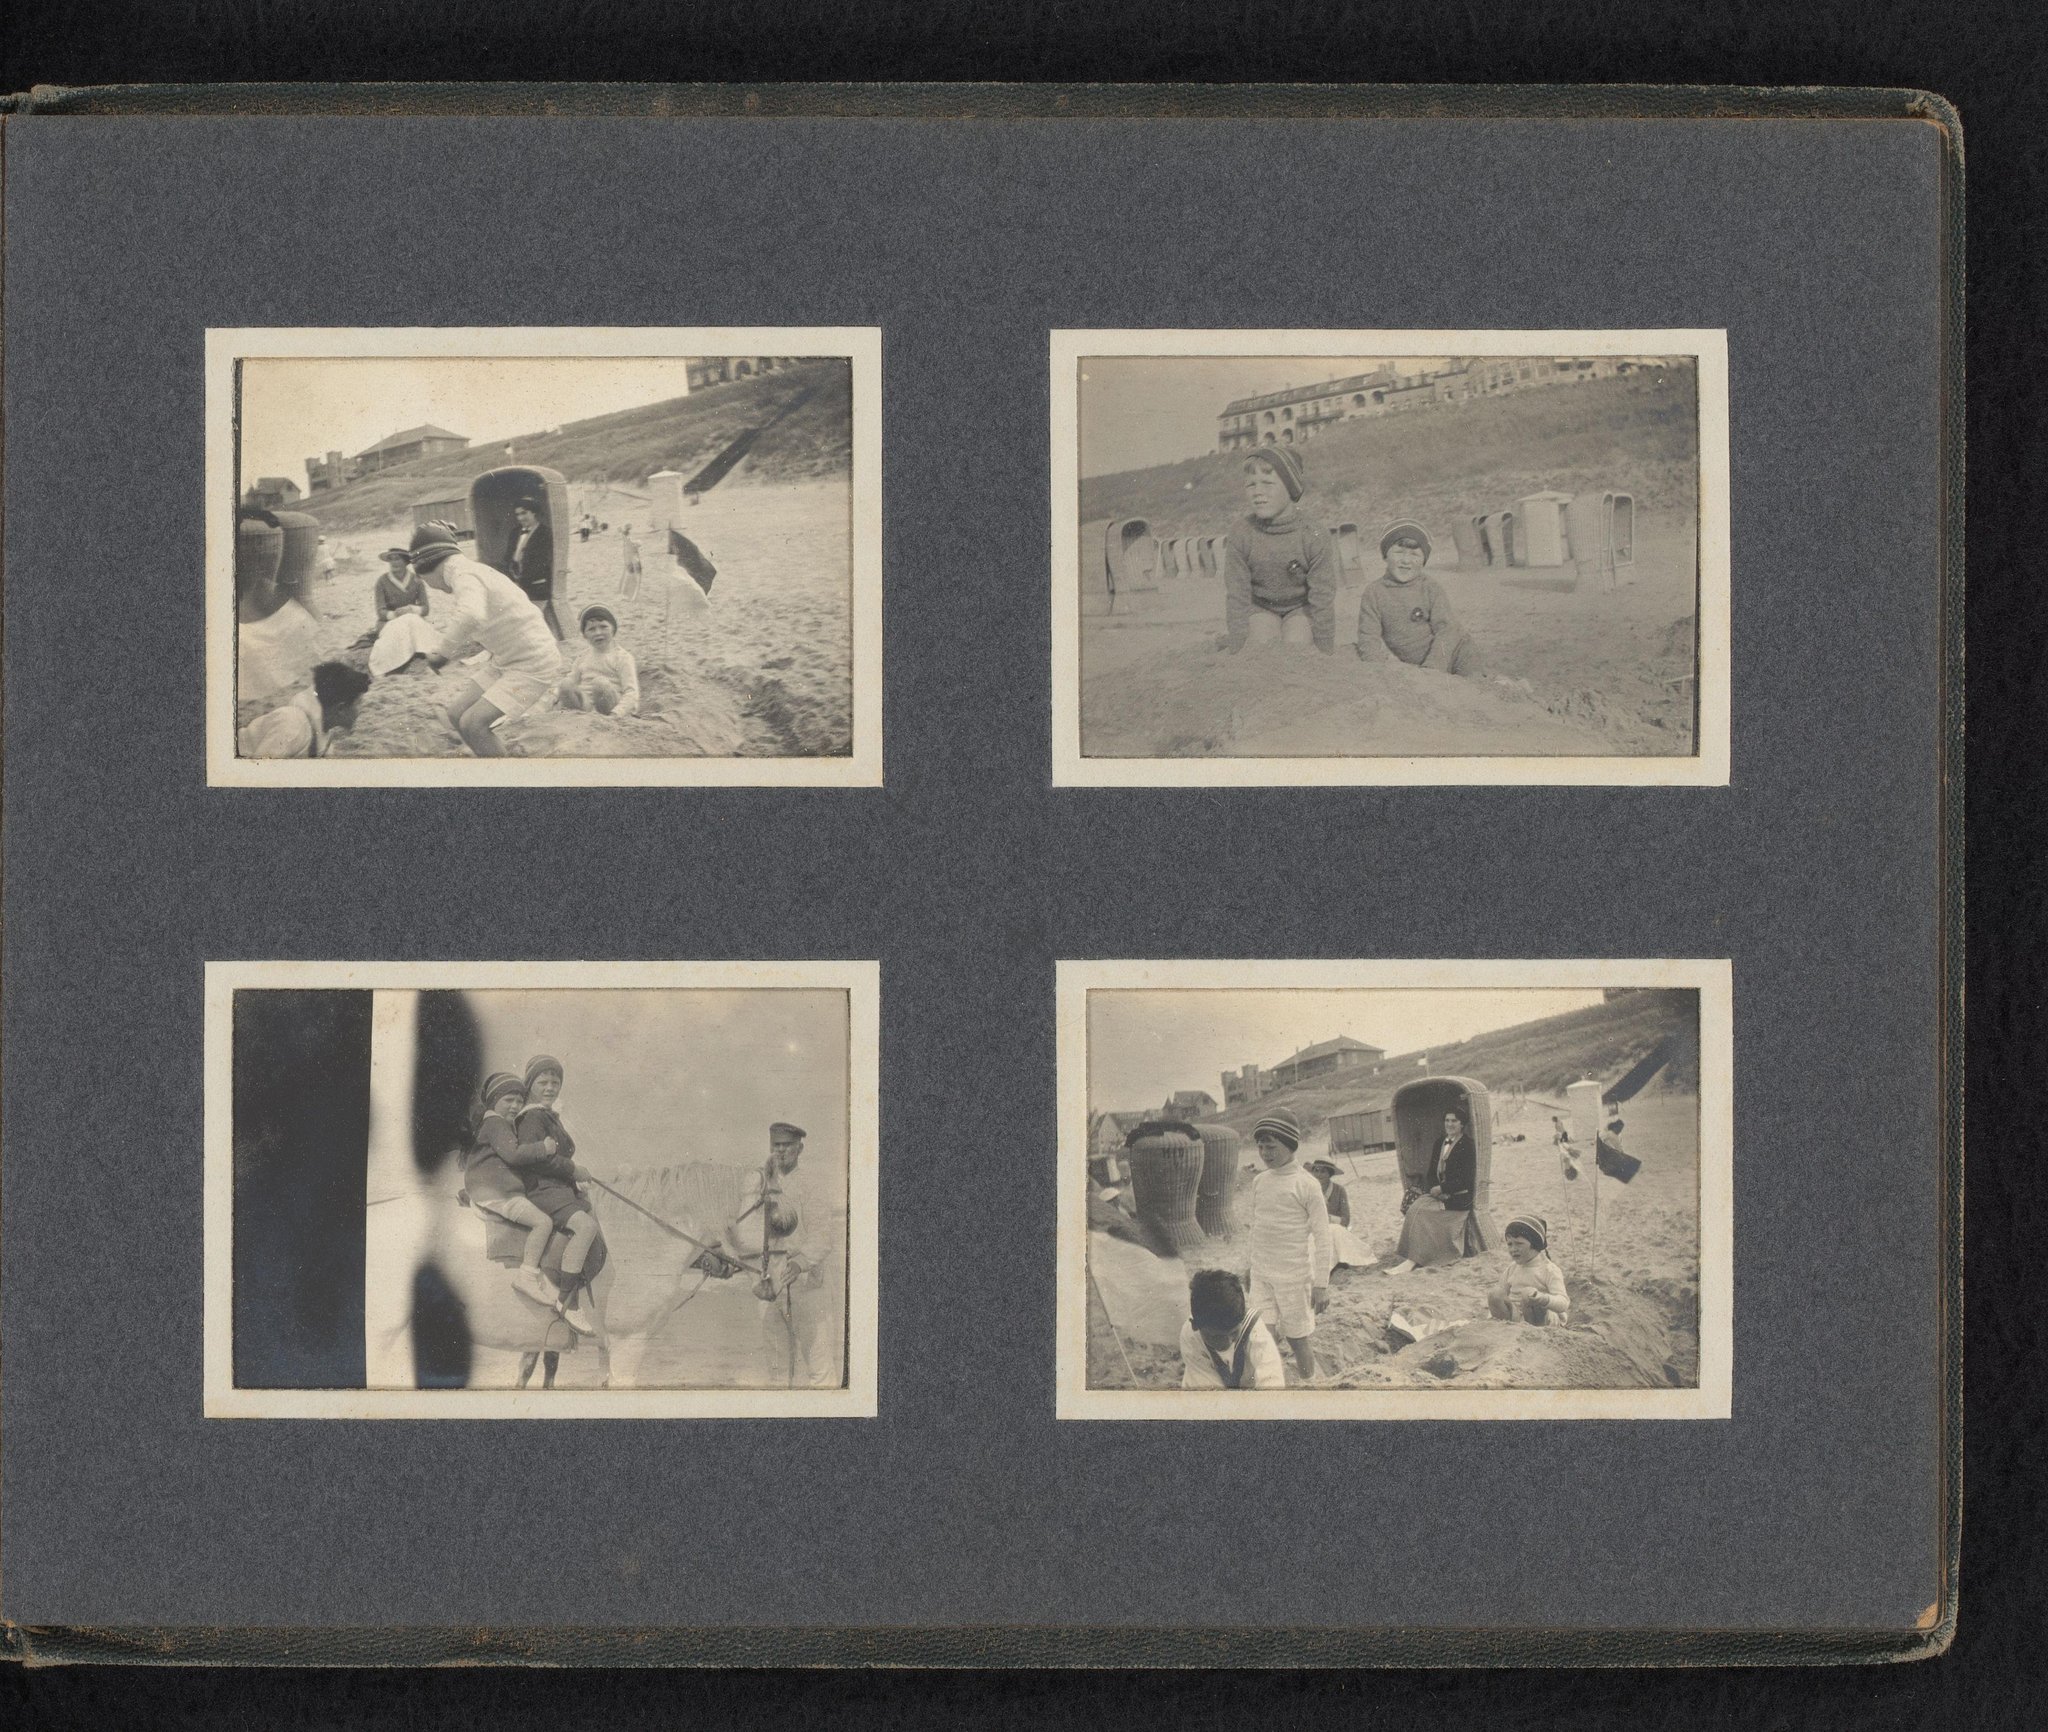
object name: photograph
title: Carel en Frank van den Berg op het strand in Noordwijk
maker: hendrik herman van den berg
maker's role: amateurfotograaf, jurist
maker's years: 1875-1944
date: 1908-1916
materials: paper, cardboard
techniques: gelatin silver print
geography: noordwijk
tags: amsterdam, carel frederik van den berg (cay), frank willem van den berg (1912-1998), beach (as place of recreation)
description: Deze foto's zijn onderdeel van een album.